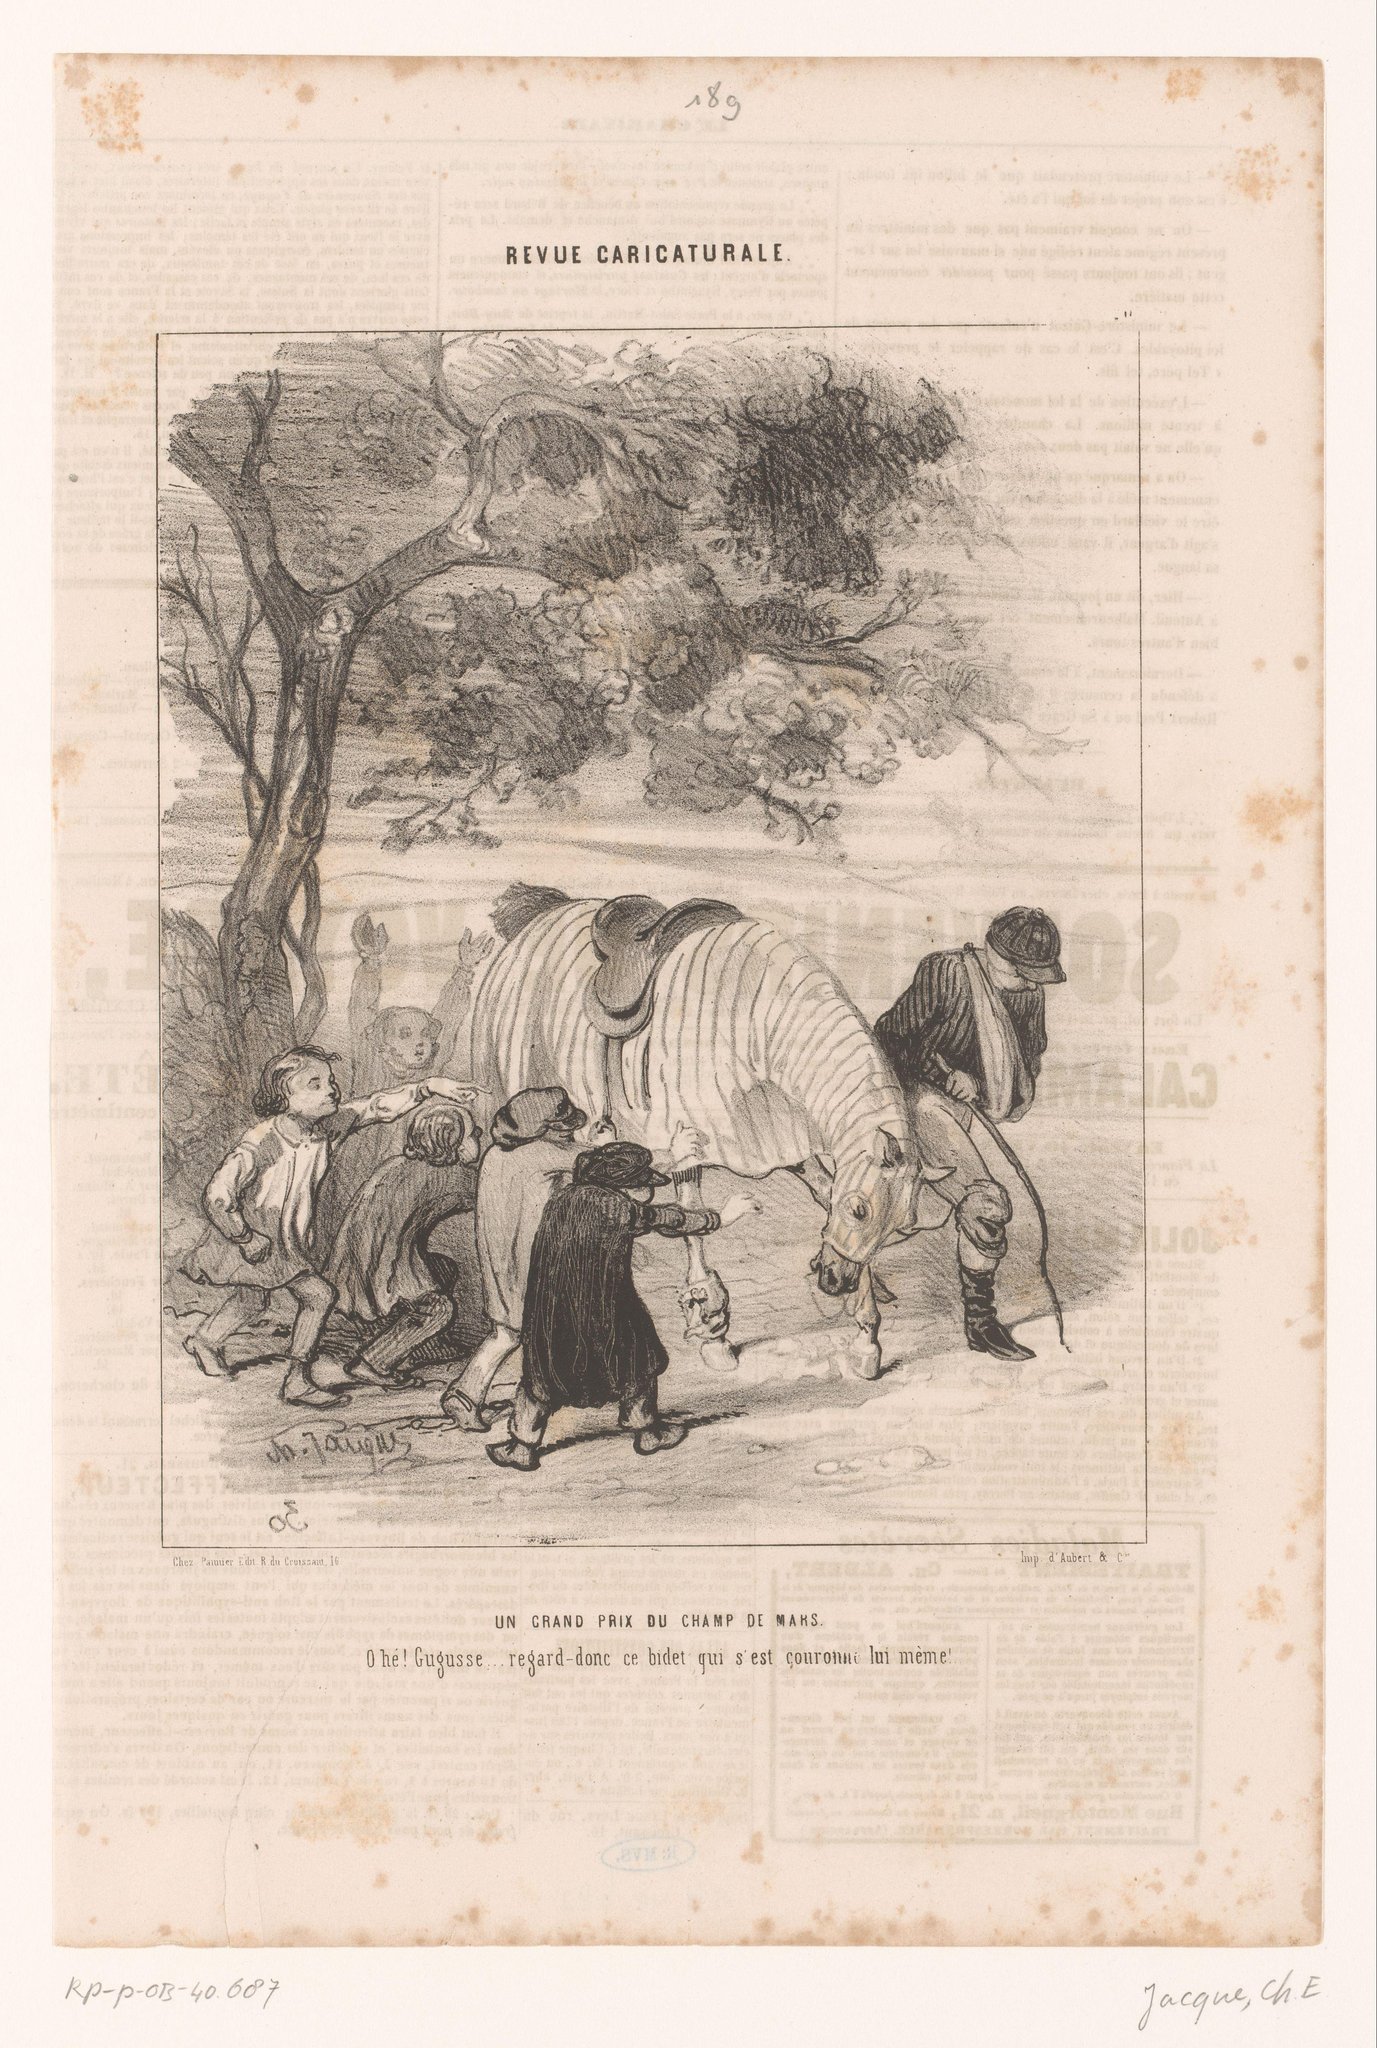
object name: cartoon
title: Un grand prix du Champs de Mars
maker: charles emile jacque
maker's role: draughtsman, painter, print maker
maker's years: 1813-1894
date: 1843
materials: paper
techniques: lithograph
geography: paris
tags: jockey (+ accident (in sports, games, etc.)), accident with horse (or kindred animal), child teasing animals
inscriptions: collector's mark: Lugt 2228a